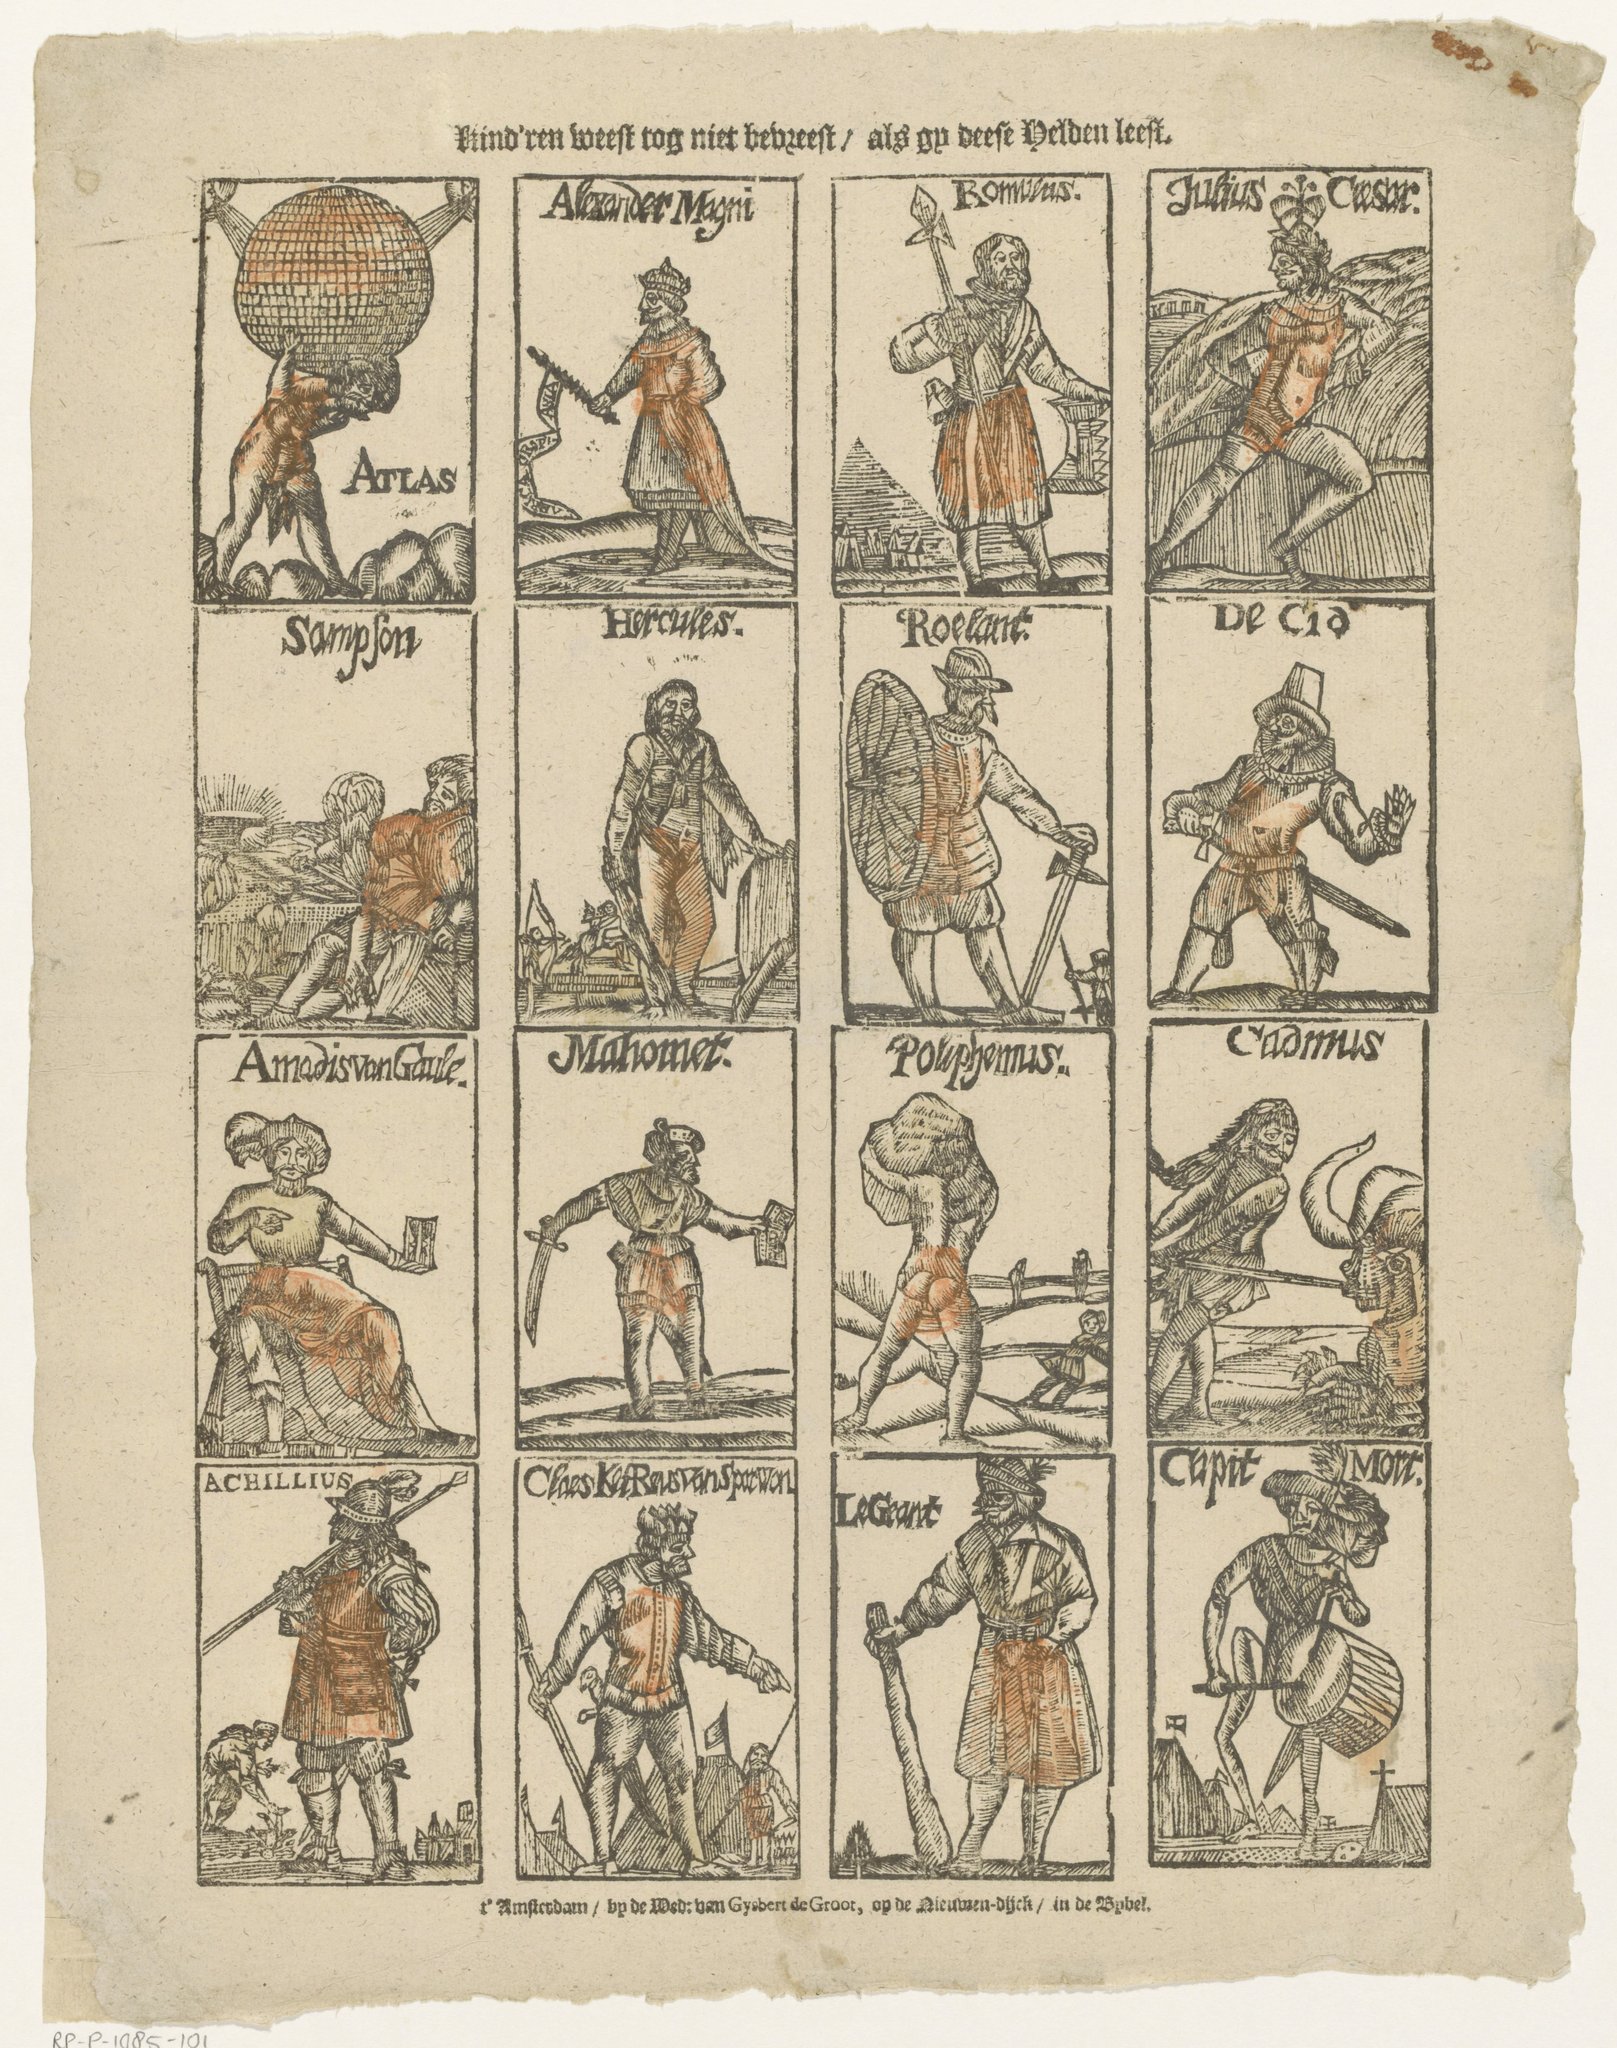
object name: print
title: Kind'ren weest tog niet bevreest / als gy deese helden leest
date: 1683-1692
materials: paper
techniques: colour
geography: amsterdam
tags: (story of) hercules (heracles), (story of) cadmus, julius caesar (one of the nine worthies)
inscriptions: collector's mark: Lugt 2228, collector's mark: Lugt 2760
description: Blad met 16 voorstellingen van mannelijke helden, waaronder Atlas, Roelant en Julius Caesar.